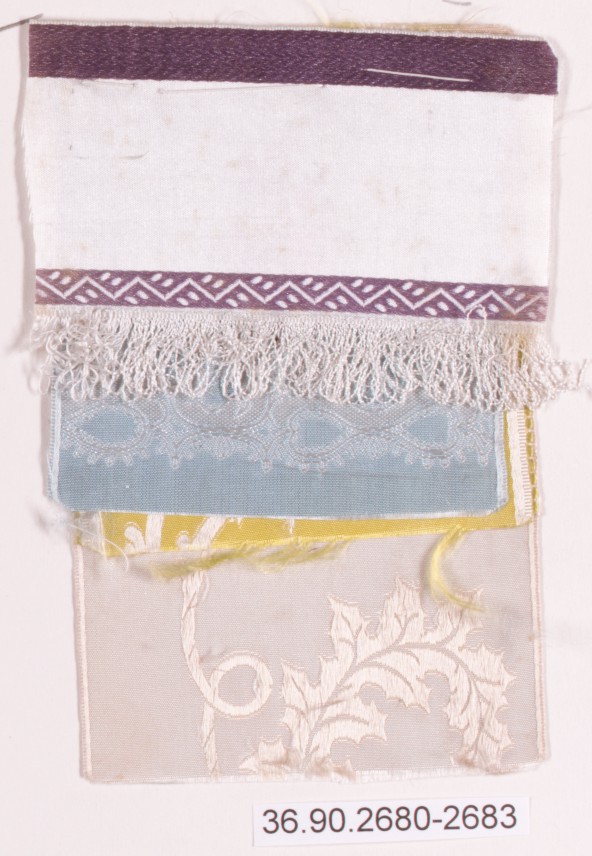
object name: ribbon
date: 1801-1900